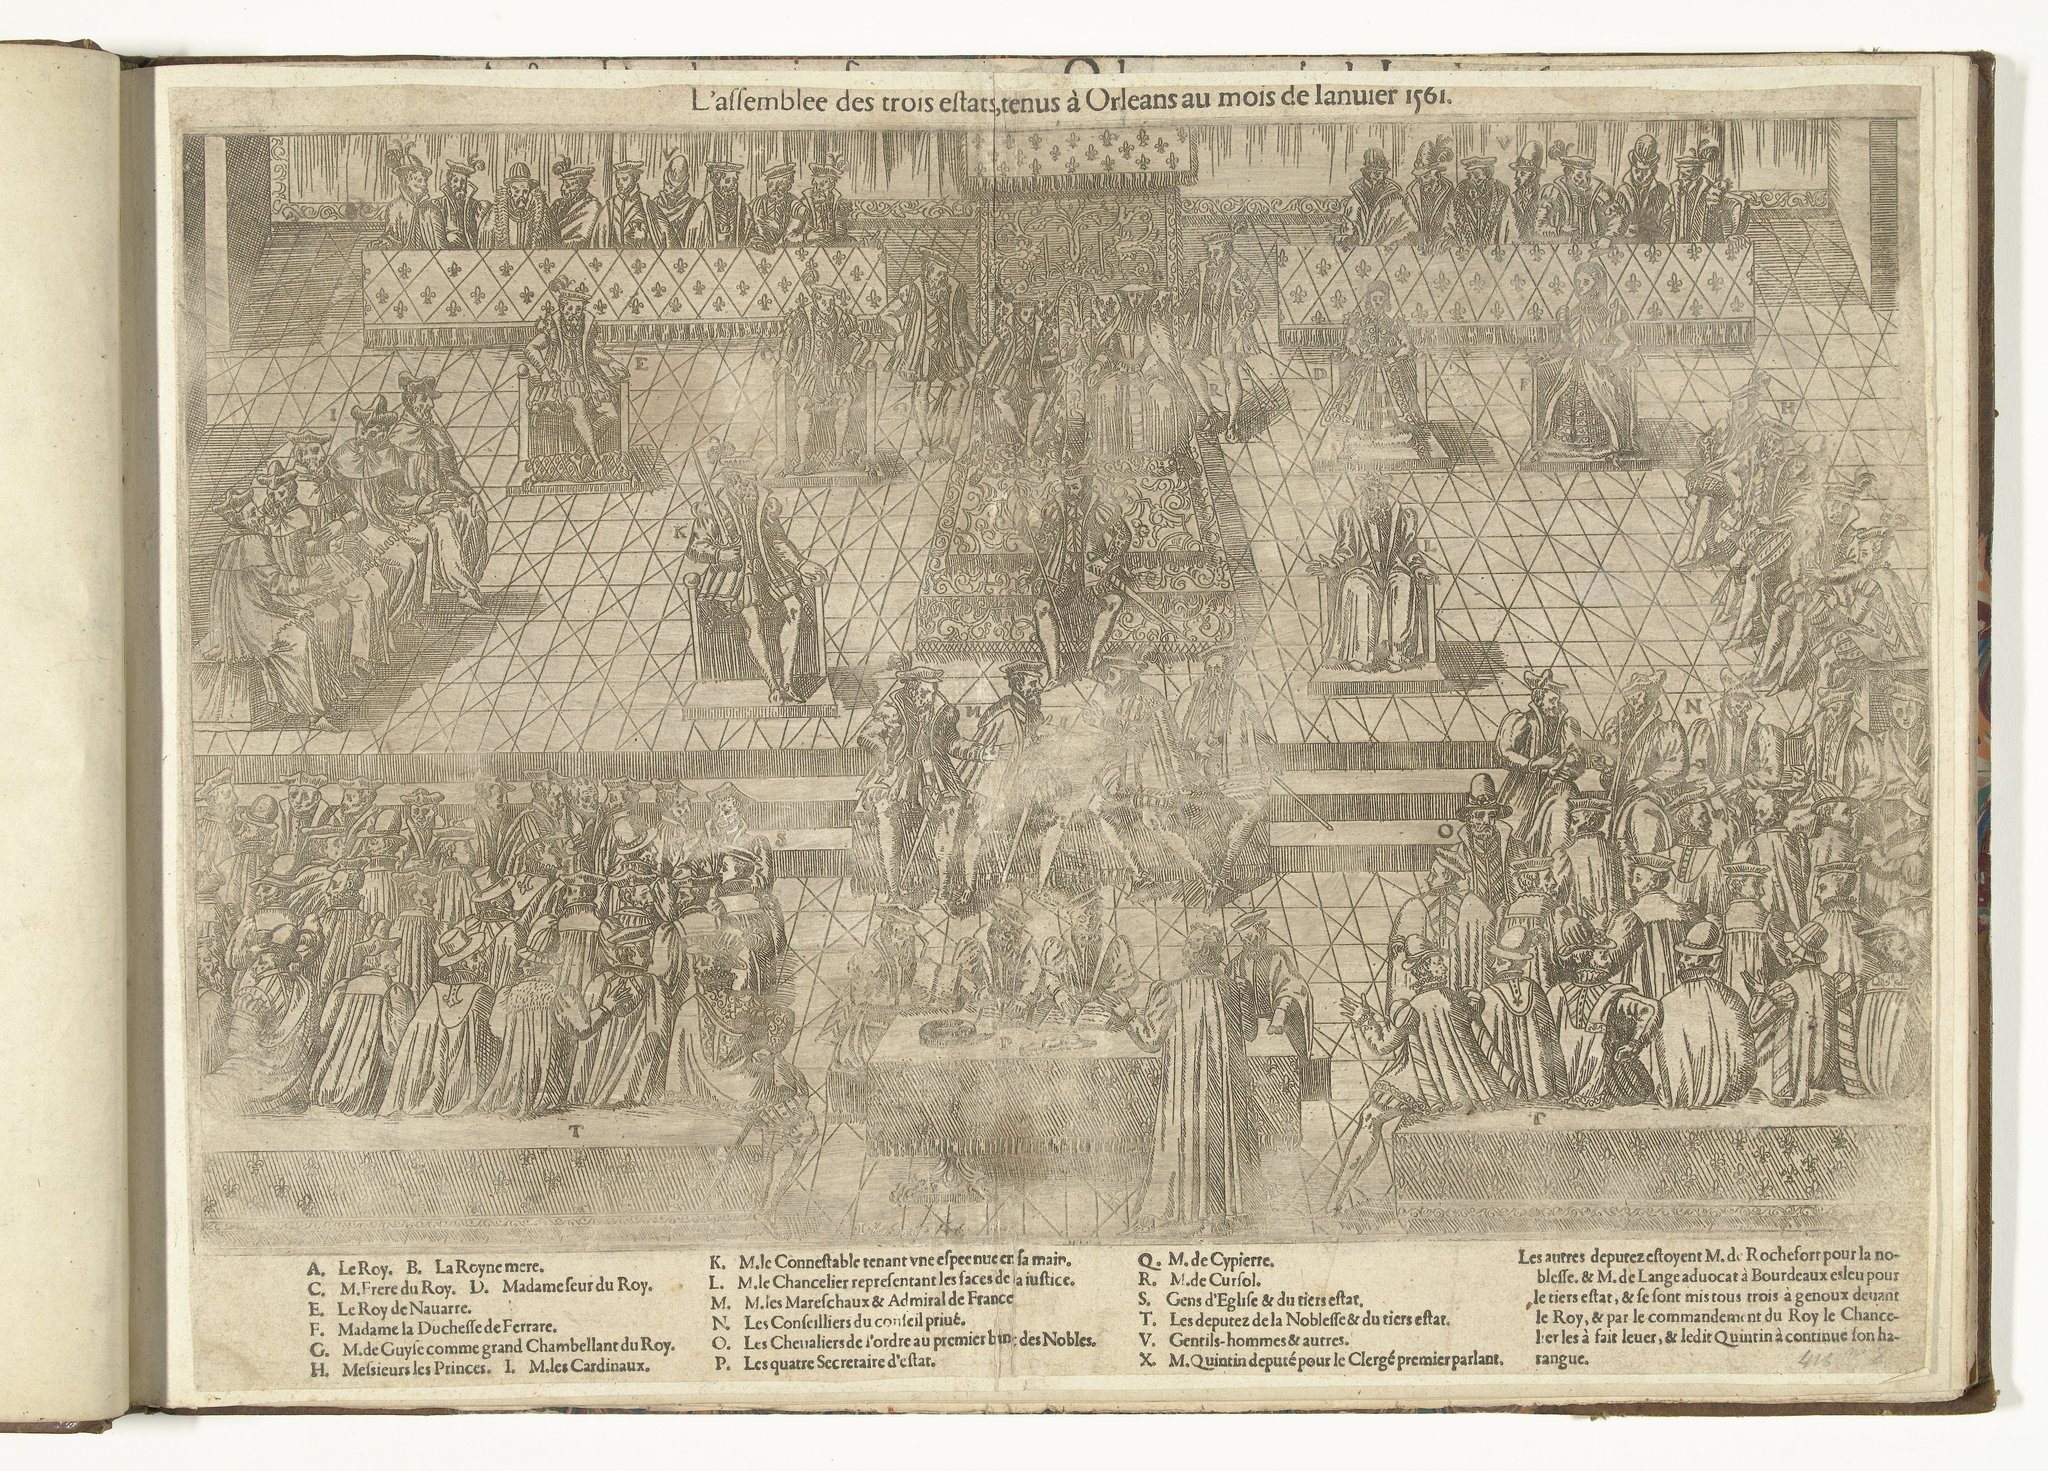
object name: history print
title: Vergadering te Orléans, 1561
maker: jacques tortorel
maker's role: print maker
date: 1570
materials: paper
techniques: etching, letterpress printing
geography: france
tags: karel ix (koning van frankrijk)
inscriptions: date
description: Vergadering van de drie standen te Orléans, januari 1561. In aanwezigheid van de koning, zijn moeder en de hertog van Guise. In het onderschrift de legenda A-X en tekstje van 6 regels in het Frans. Ongenummerd.